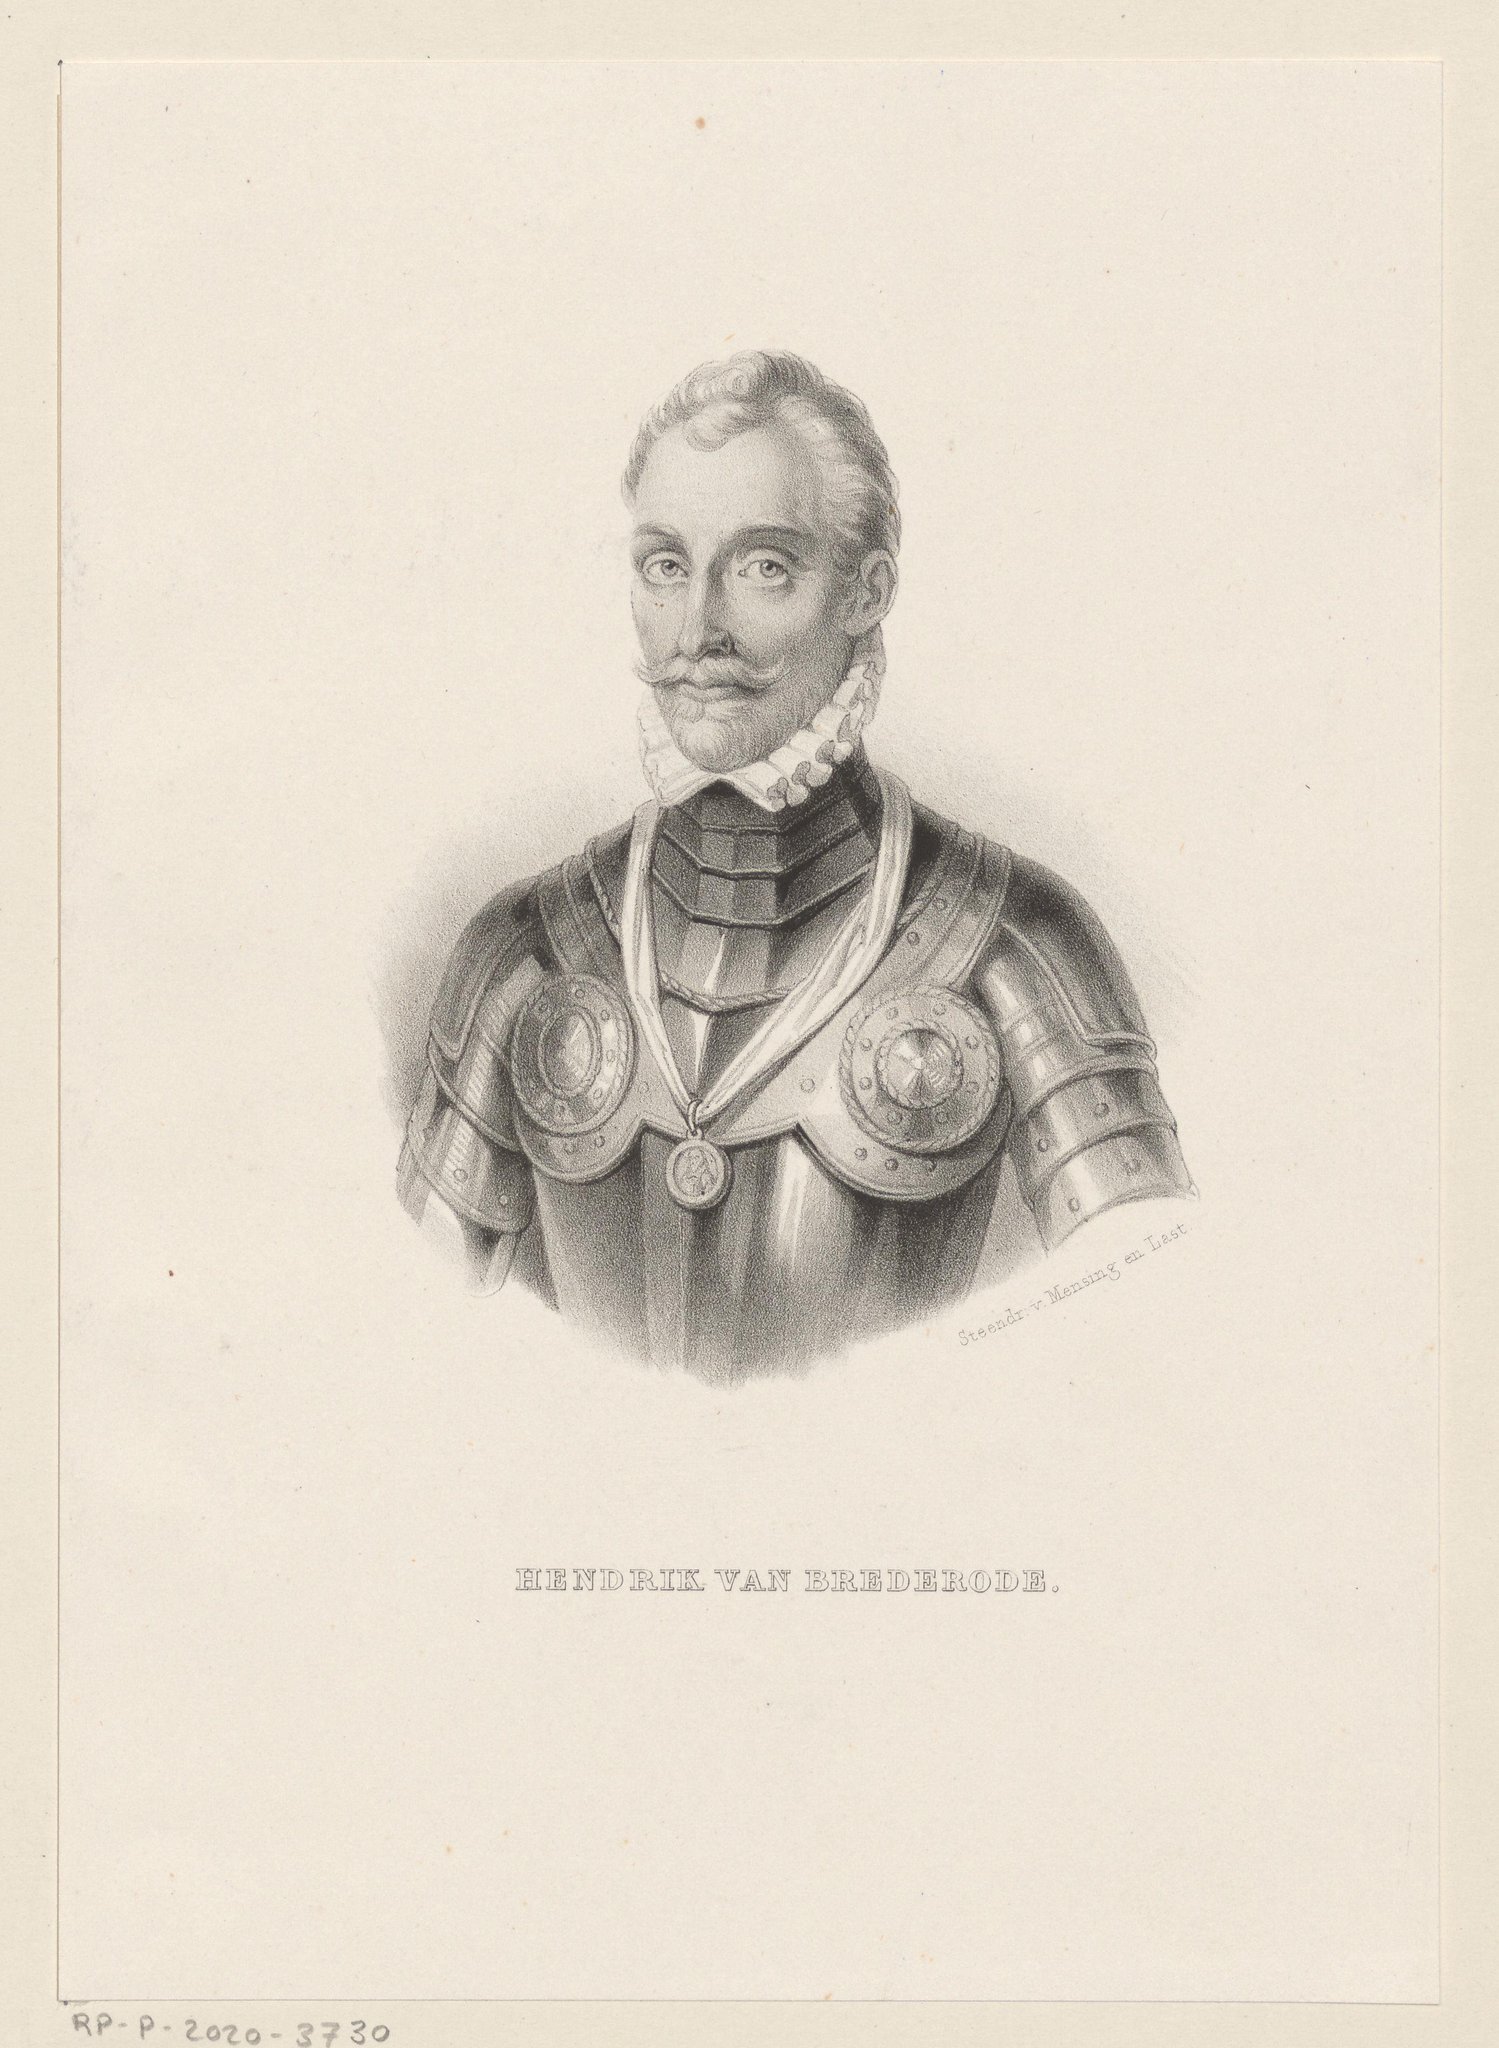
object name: print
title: Portret van Hendrik van Brederode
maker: Anonymous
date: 1846-1847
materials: paper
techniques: lithograph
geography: the hague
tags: armour, historical persons